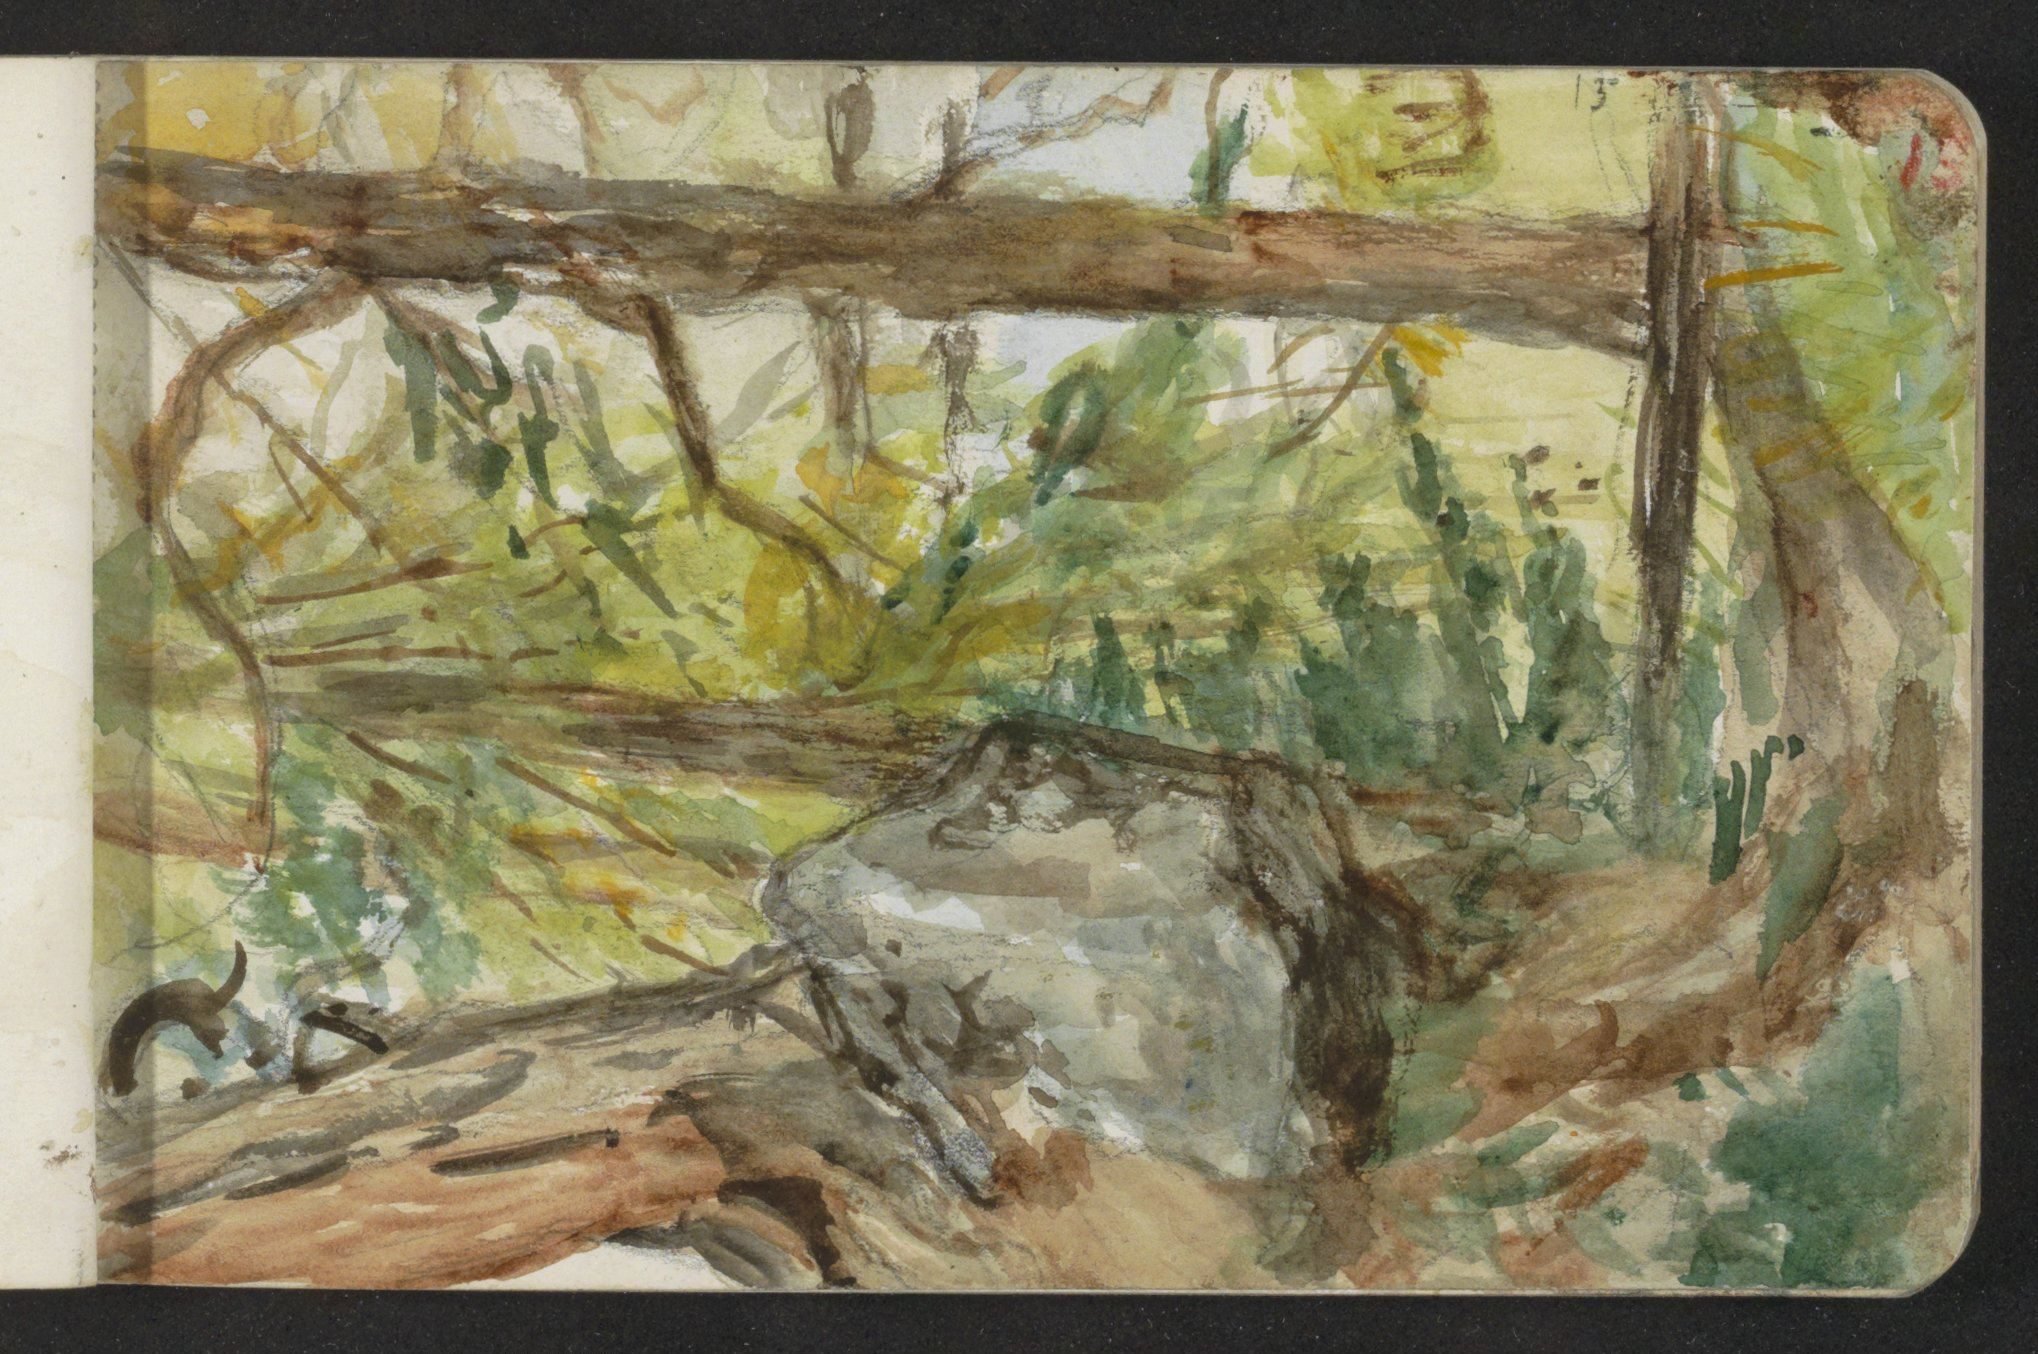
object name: sketchbook leaf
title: Bos in Pontresina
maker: jozef israëls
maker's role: draughtsman, painter, print maker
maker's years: 1824-1911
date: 1869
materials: paper, pencil, watercolor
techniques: brush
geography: pontresina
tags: forest, wood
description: Blad 13 recto uit een schetsboek met 36 bladen.